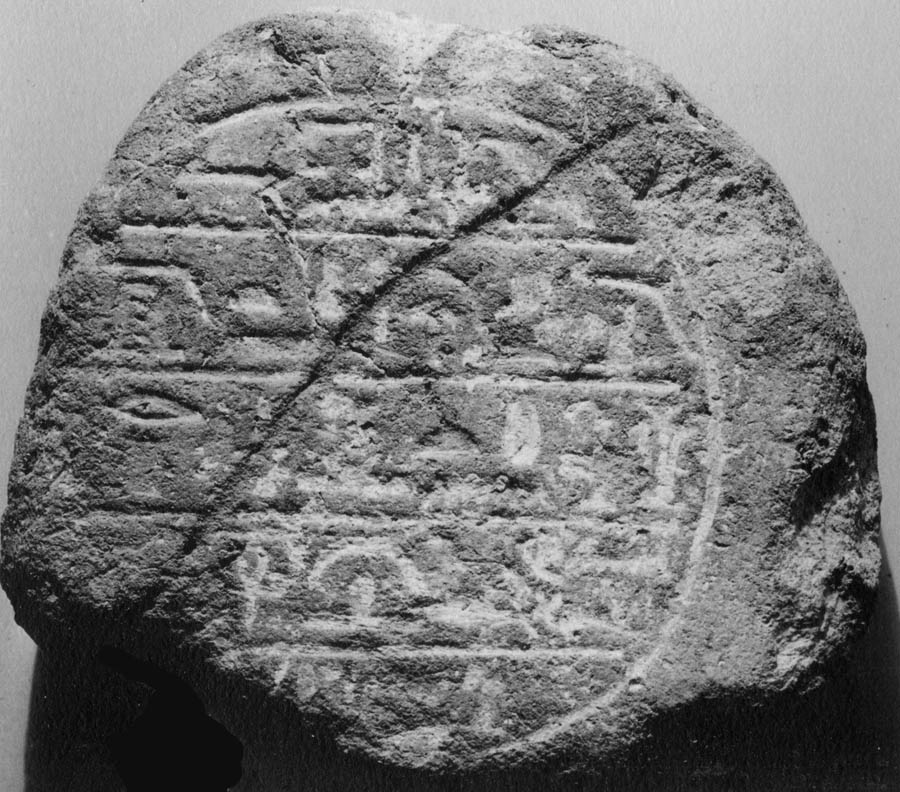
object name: cone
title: Funerary Cone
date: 1550-1295 BCE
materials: pottery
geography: egypt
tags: hieroglyphs